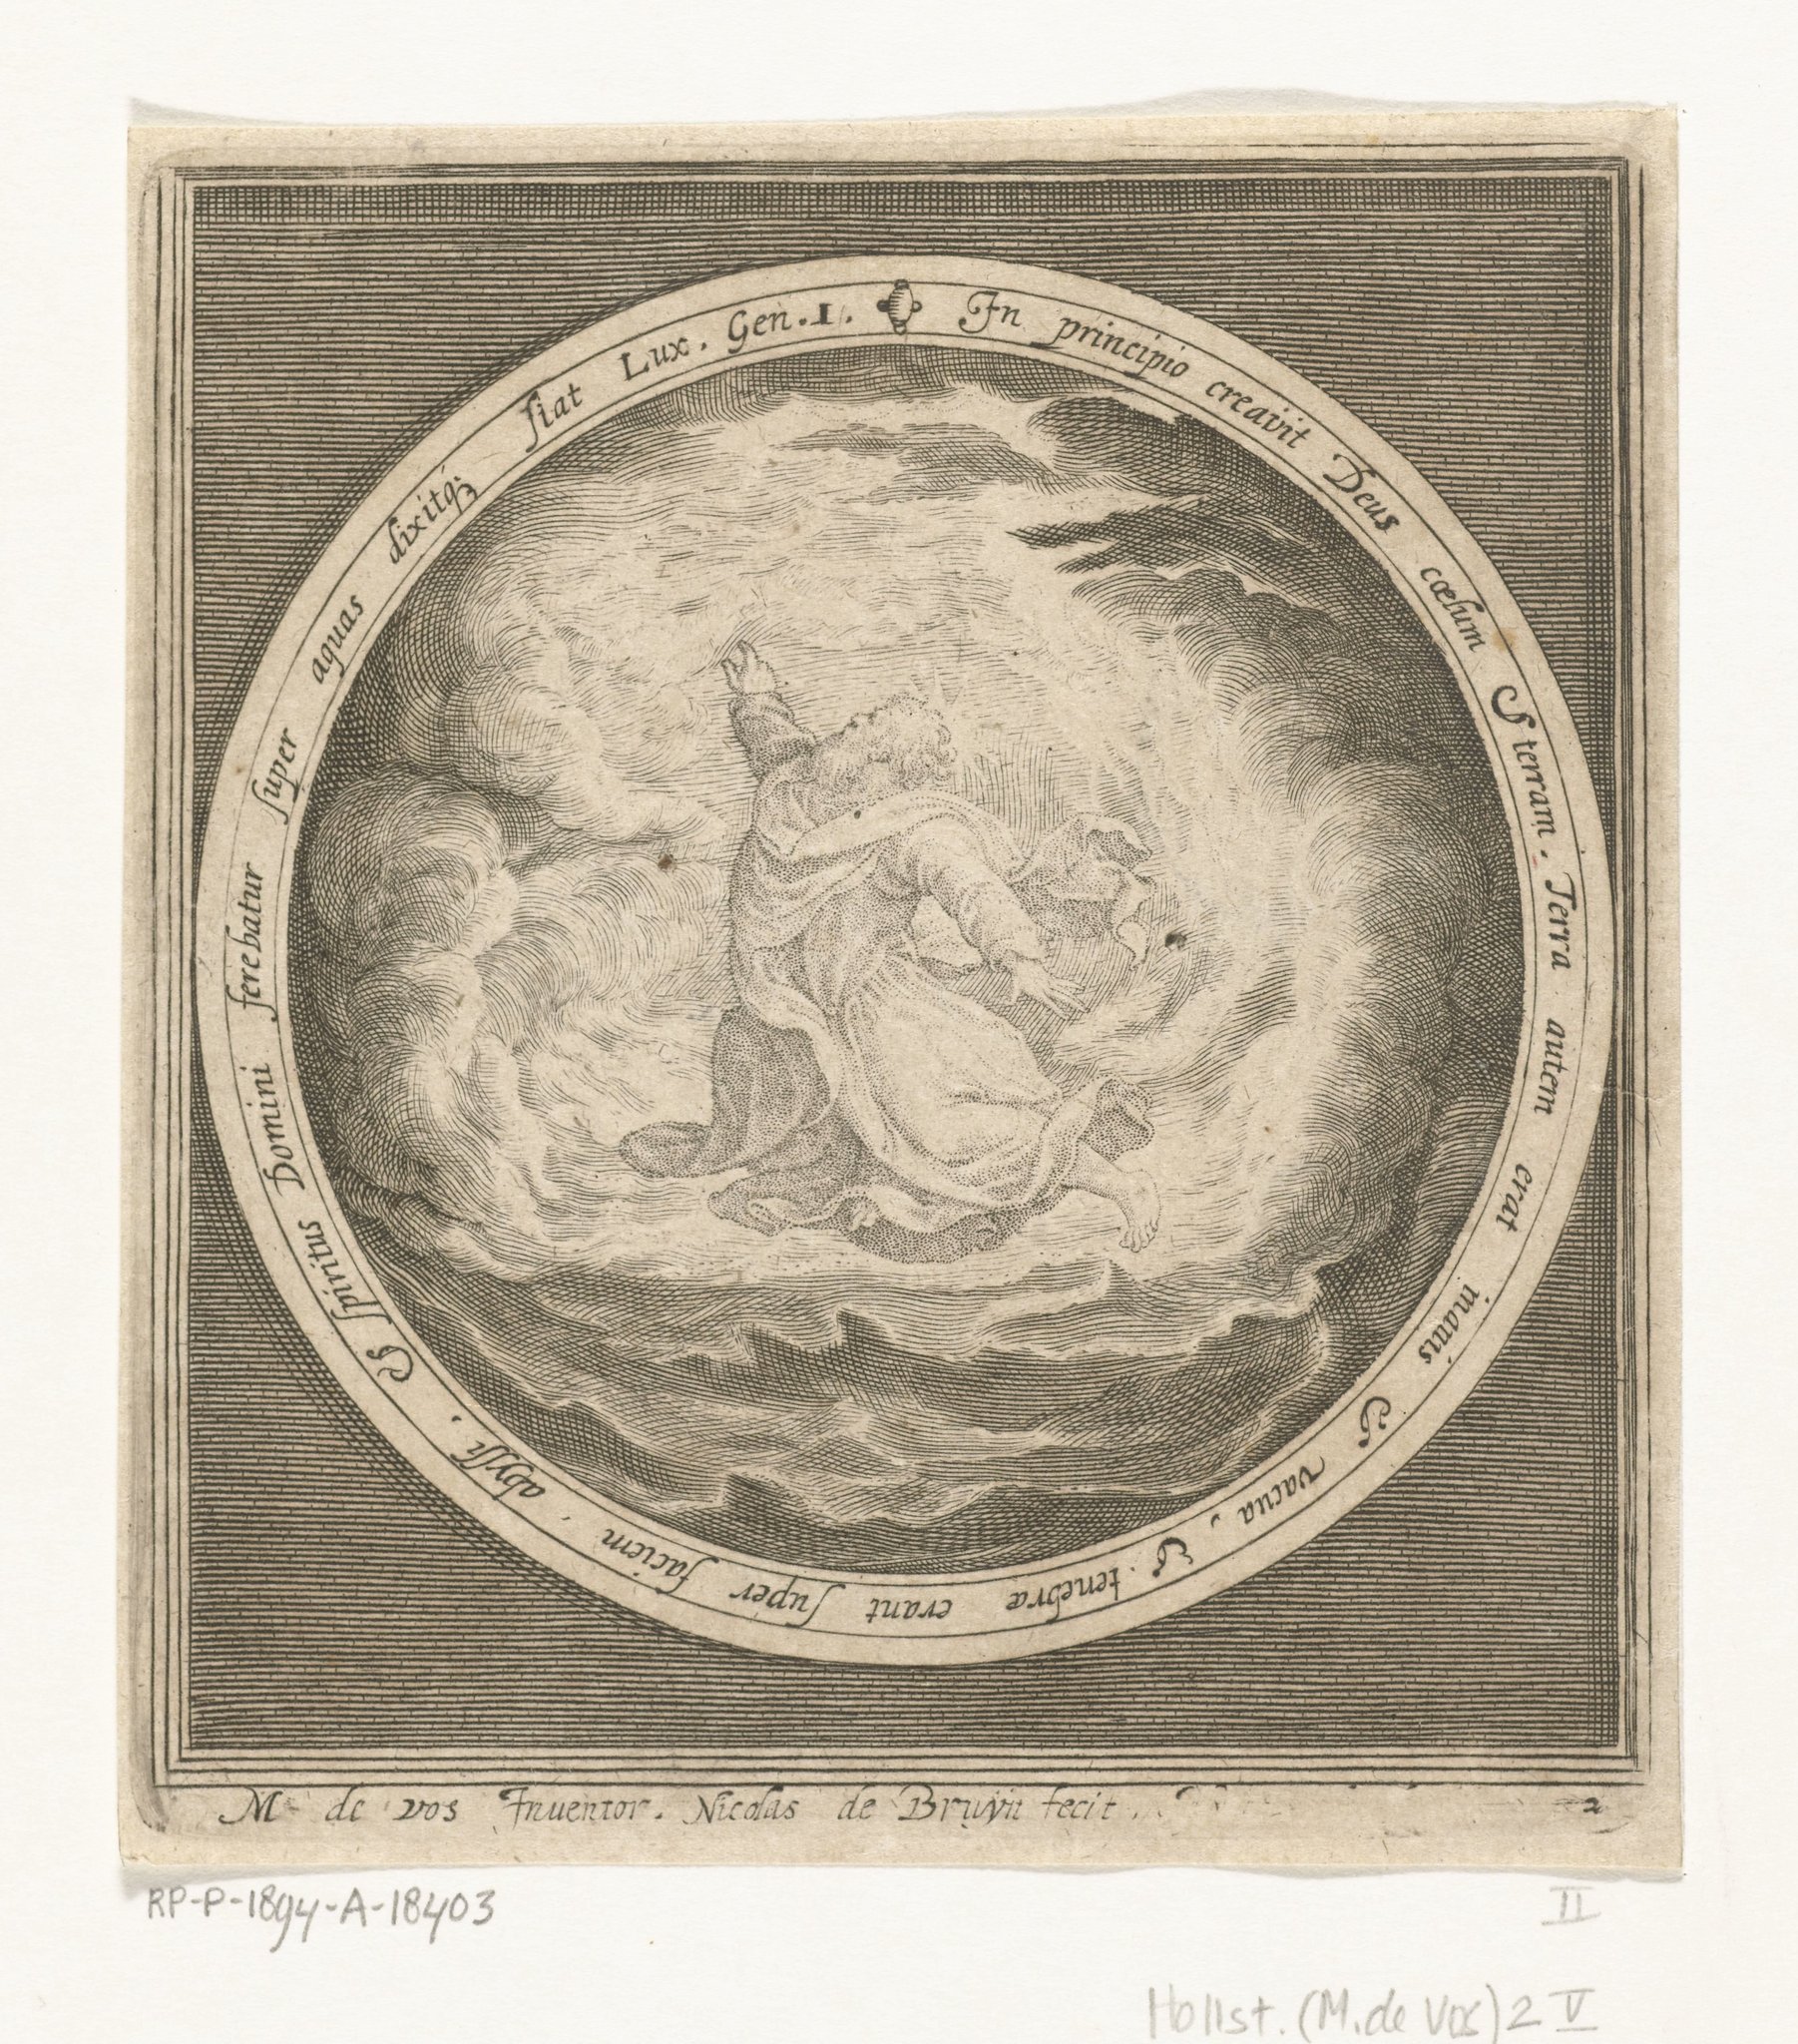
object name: print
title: Van schepping tot verdrijving uit paradijs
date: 1581-1656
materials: paper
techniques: engraving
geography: netherlands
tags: division of light and darkness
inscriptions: collector's mark: Lugt 2228, collector's mark: Lugt 2482, collector's mark: Lugt 1606, collector's mark: Lugt 2510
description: Eerste dag van schepping: God schept hemel en aarde. In medaillon met als opschrift een bijbeltekst in Latijn uit Genesis 1, binnen rechthoekige omlijsting.